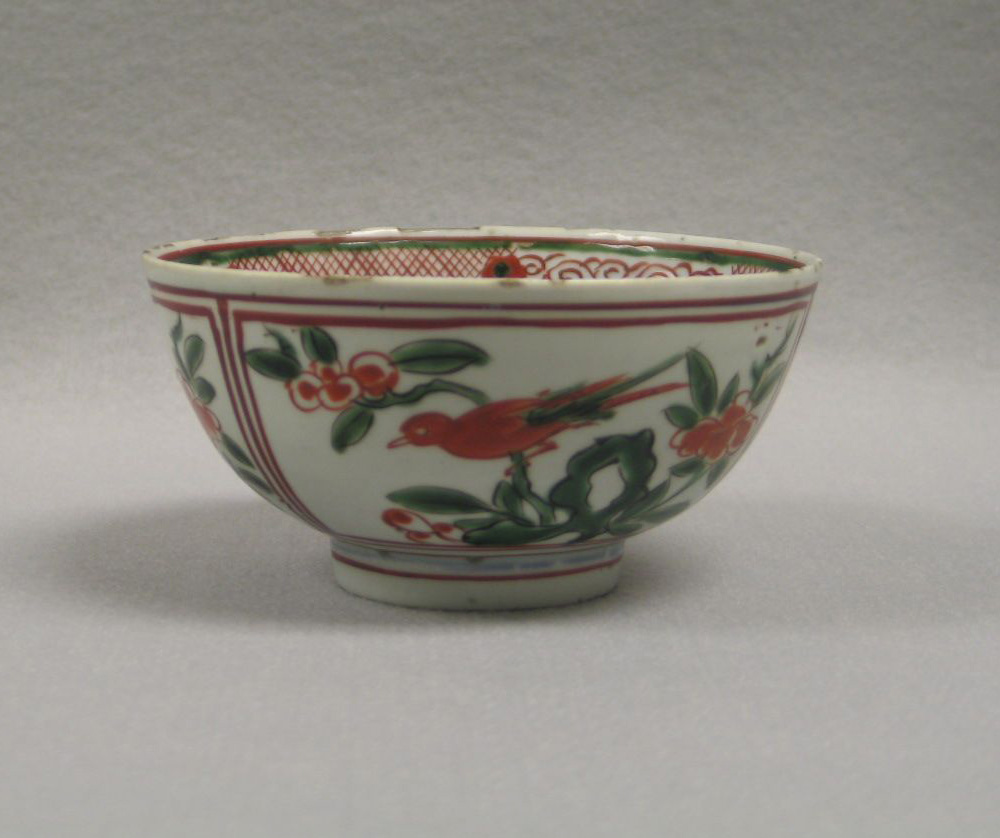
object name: bowl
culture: chinese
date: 1426-1435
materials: enamel, iron, porcelain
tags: birds,leaves